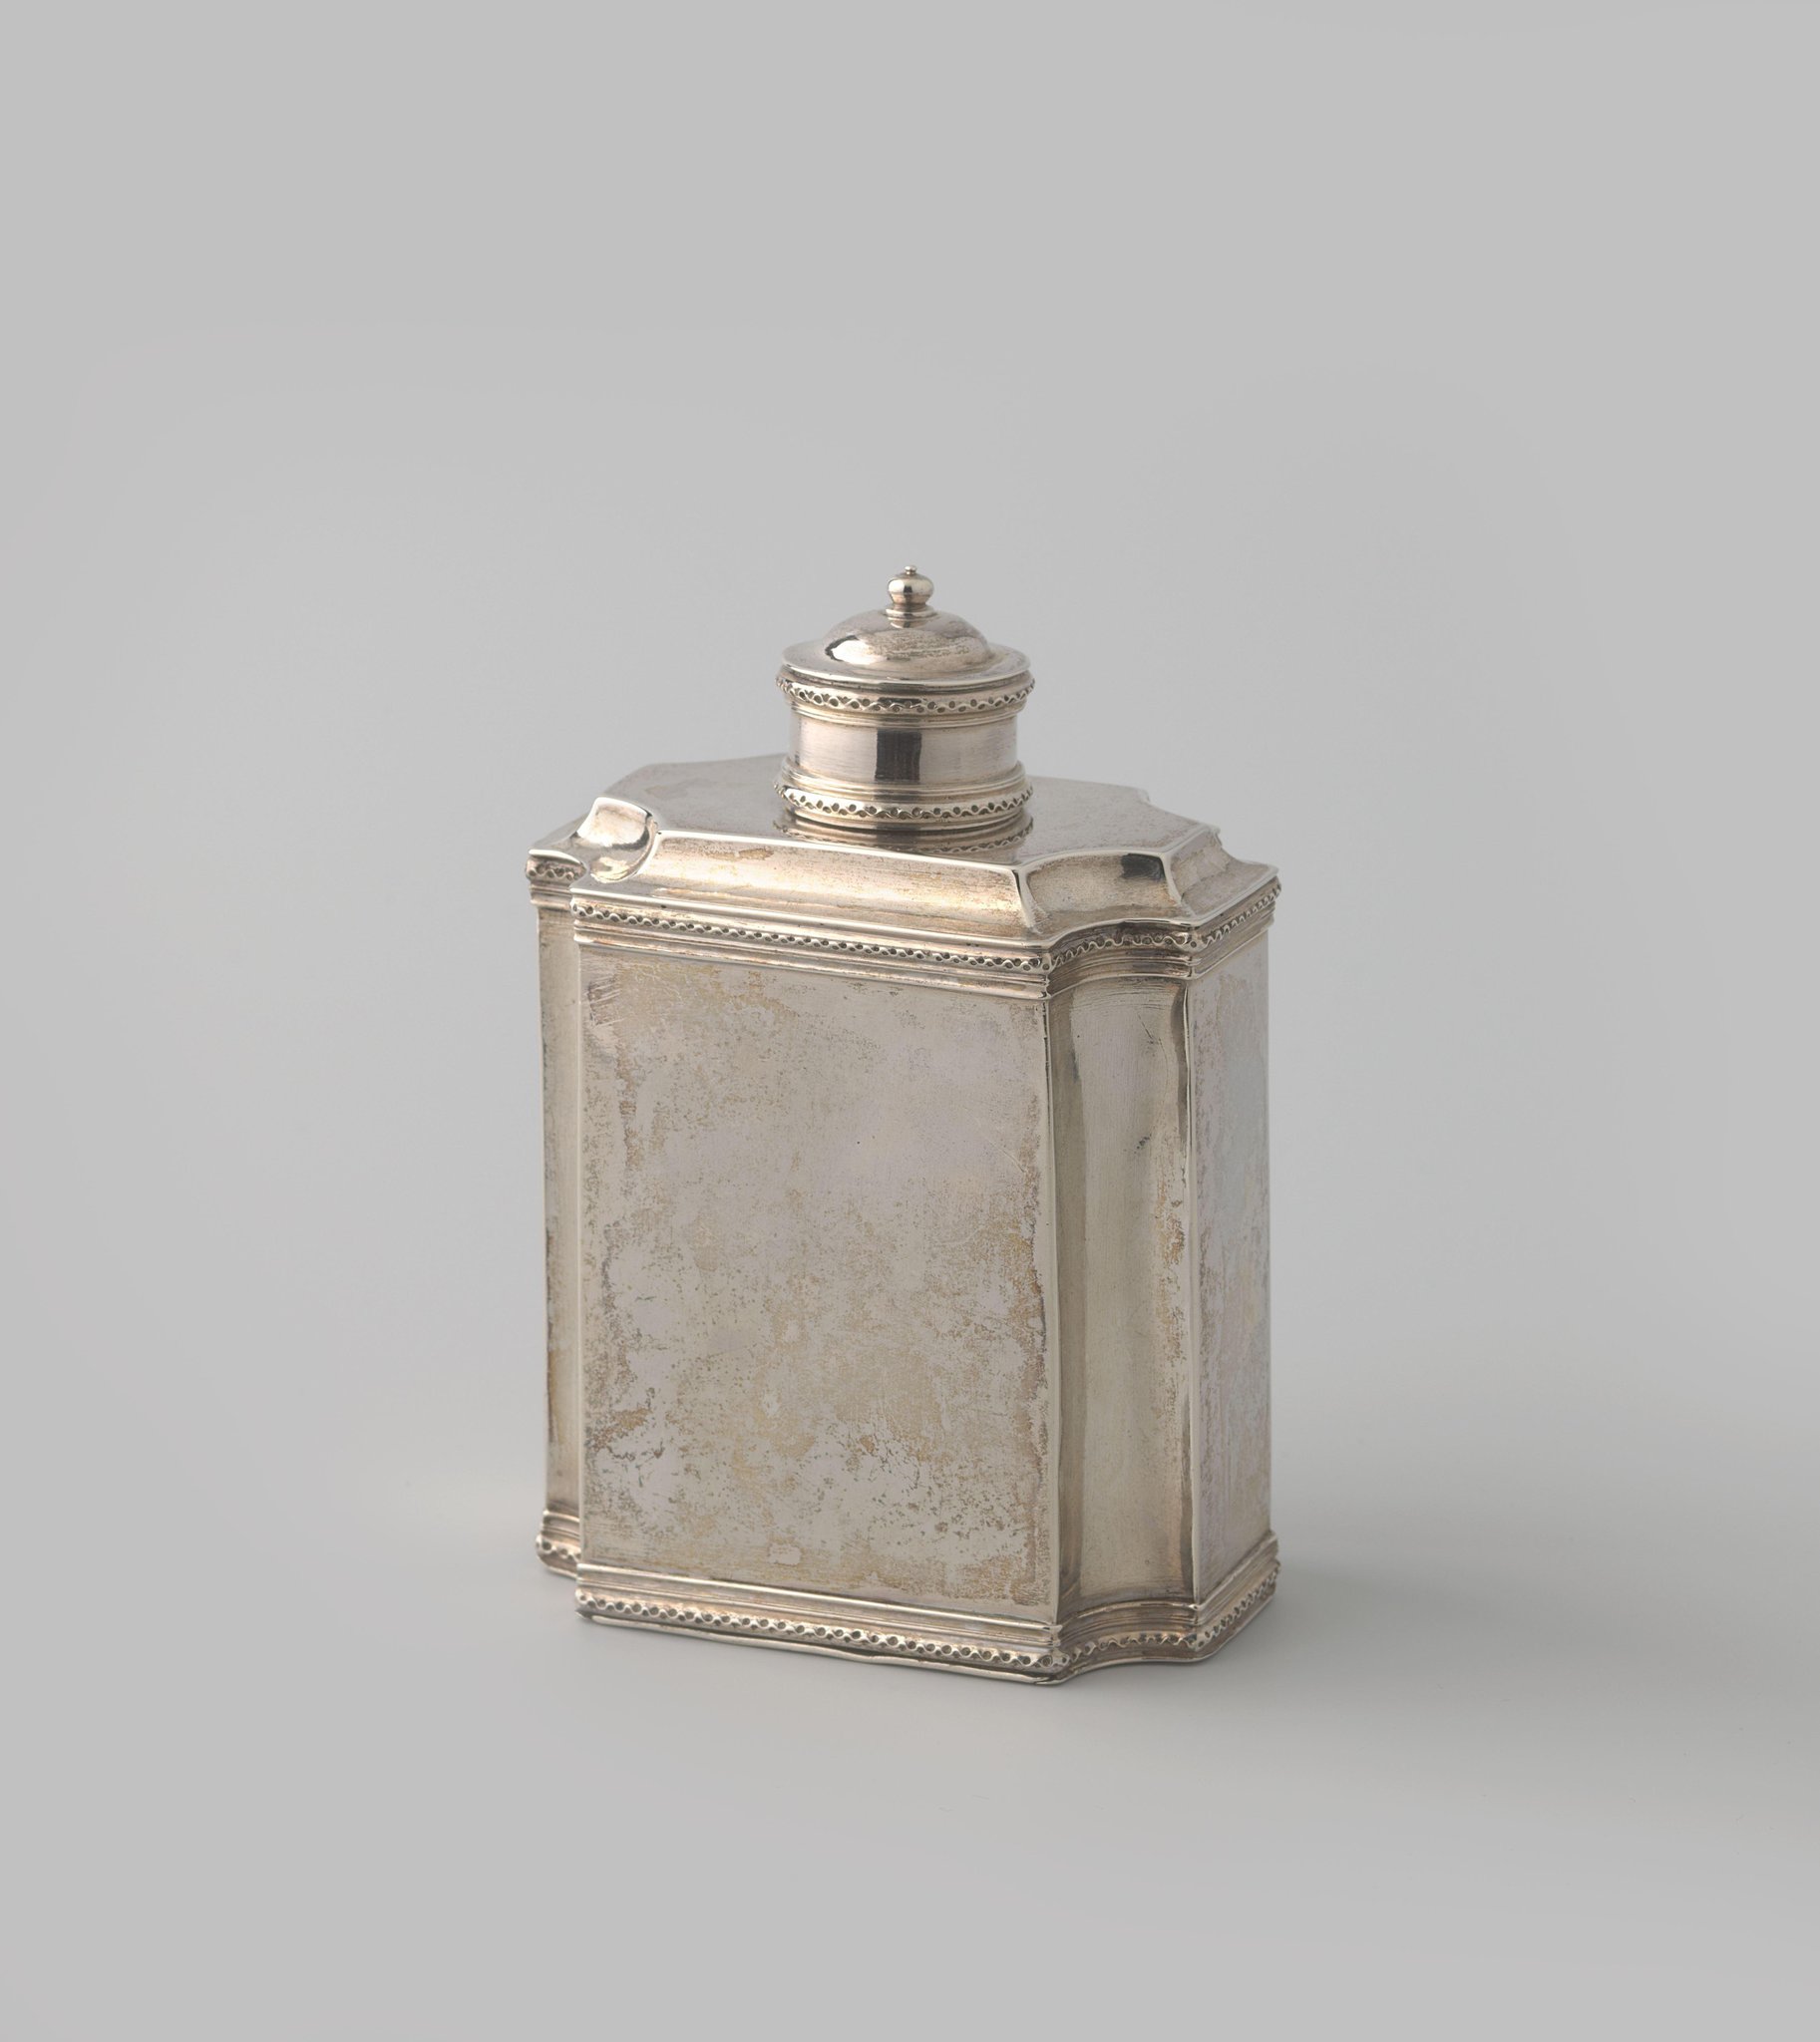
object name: tea caddy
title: Theebus, glad en afgezet met slingerranden.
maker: andreas somers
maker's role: silversmith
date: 1701-1702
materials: silver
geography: den bosch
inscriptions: maker's mark, town mark, date letter: ‘B’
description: Tea caddy. Silver. 's-Hertogenbosch, 1701, by Andreas Somers.